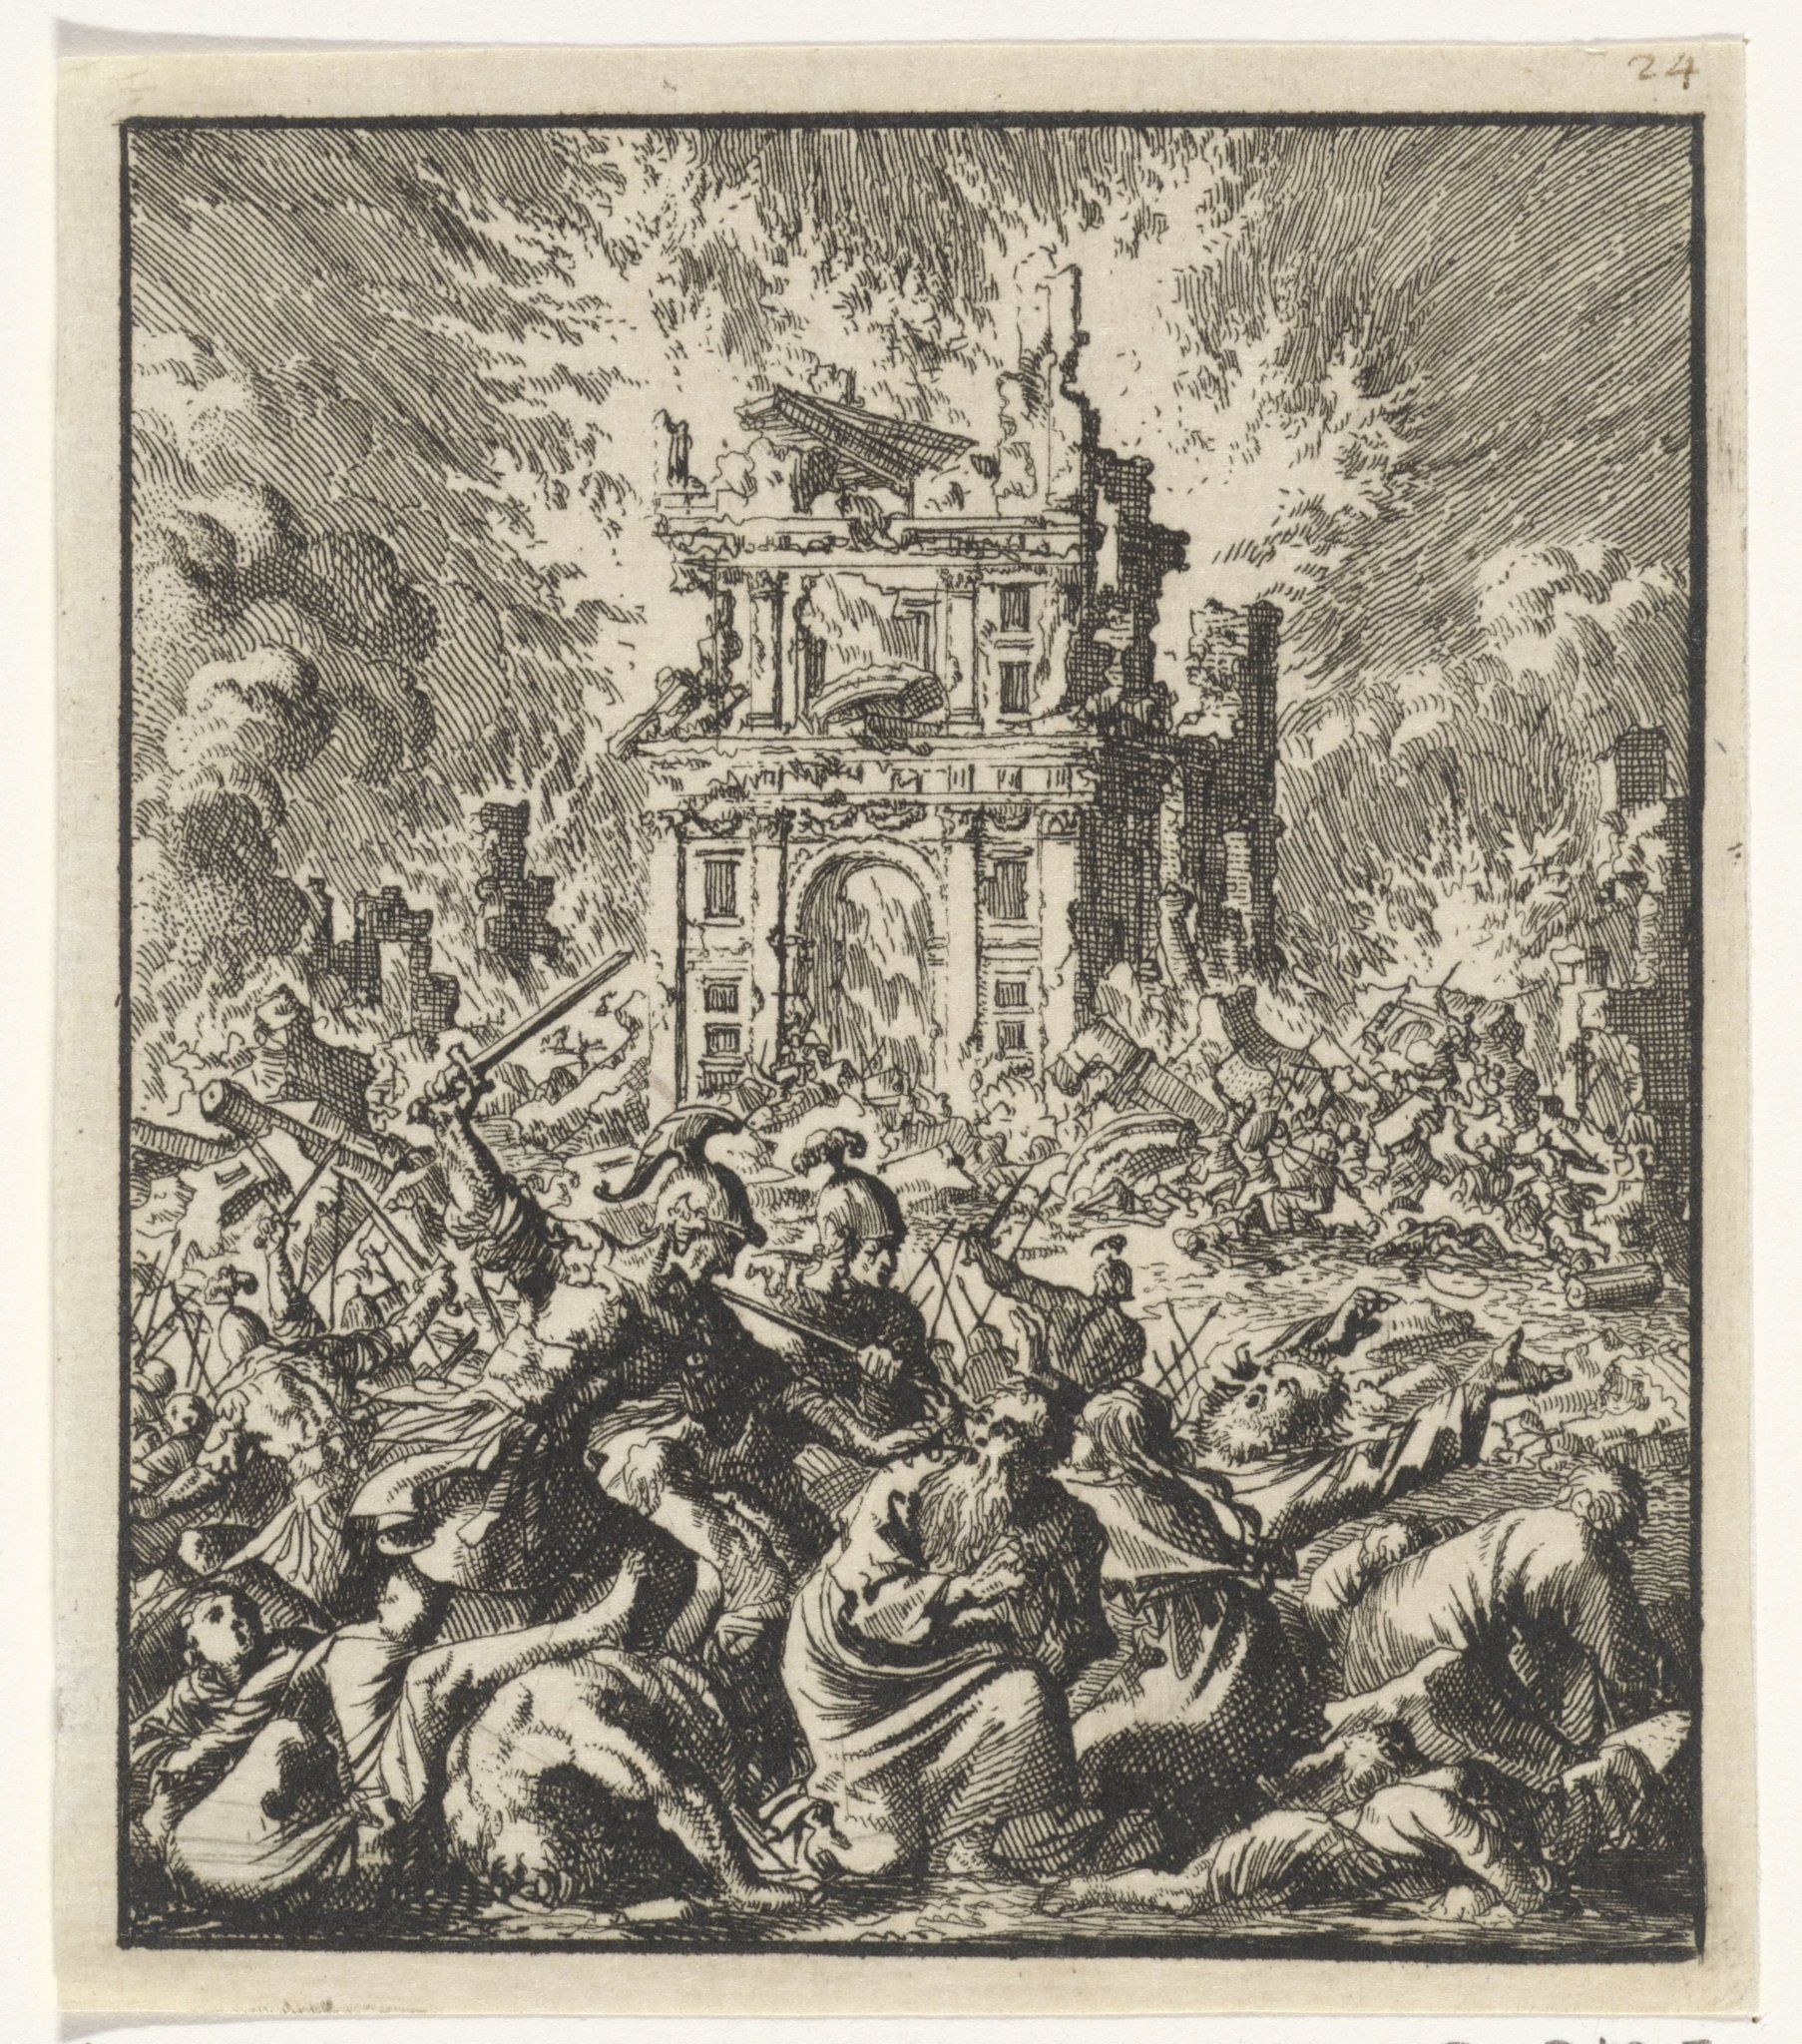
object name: book illustration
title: Romeinen doden de Joden, terwijl de Tempel brandt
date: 1706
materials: paper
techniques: etching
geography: amsterdam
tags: (military) attack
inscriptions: collector's mark: Lugt 2228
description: Illustratie voor: Schabaalje, Jean Philipsz. De vermeerderde lust-hof des gemoeds. Amsterdam: Jan Rieuwertsz. (II) en Barent Visscher, 1706, p. 499.